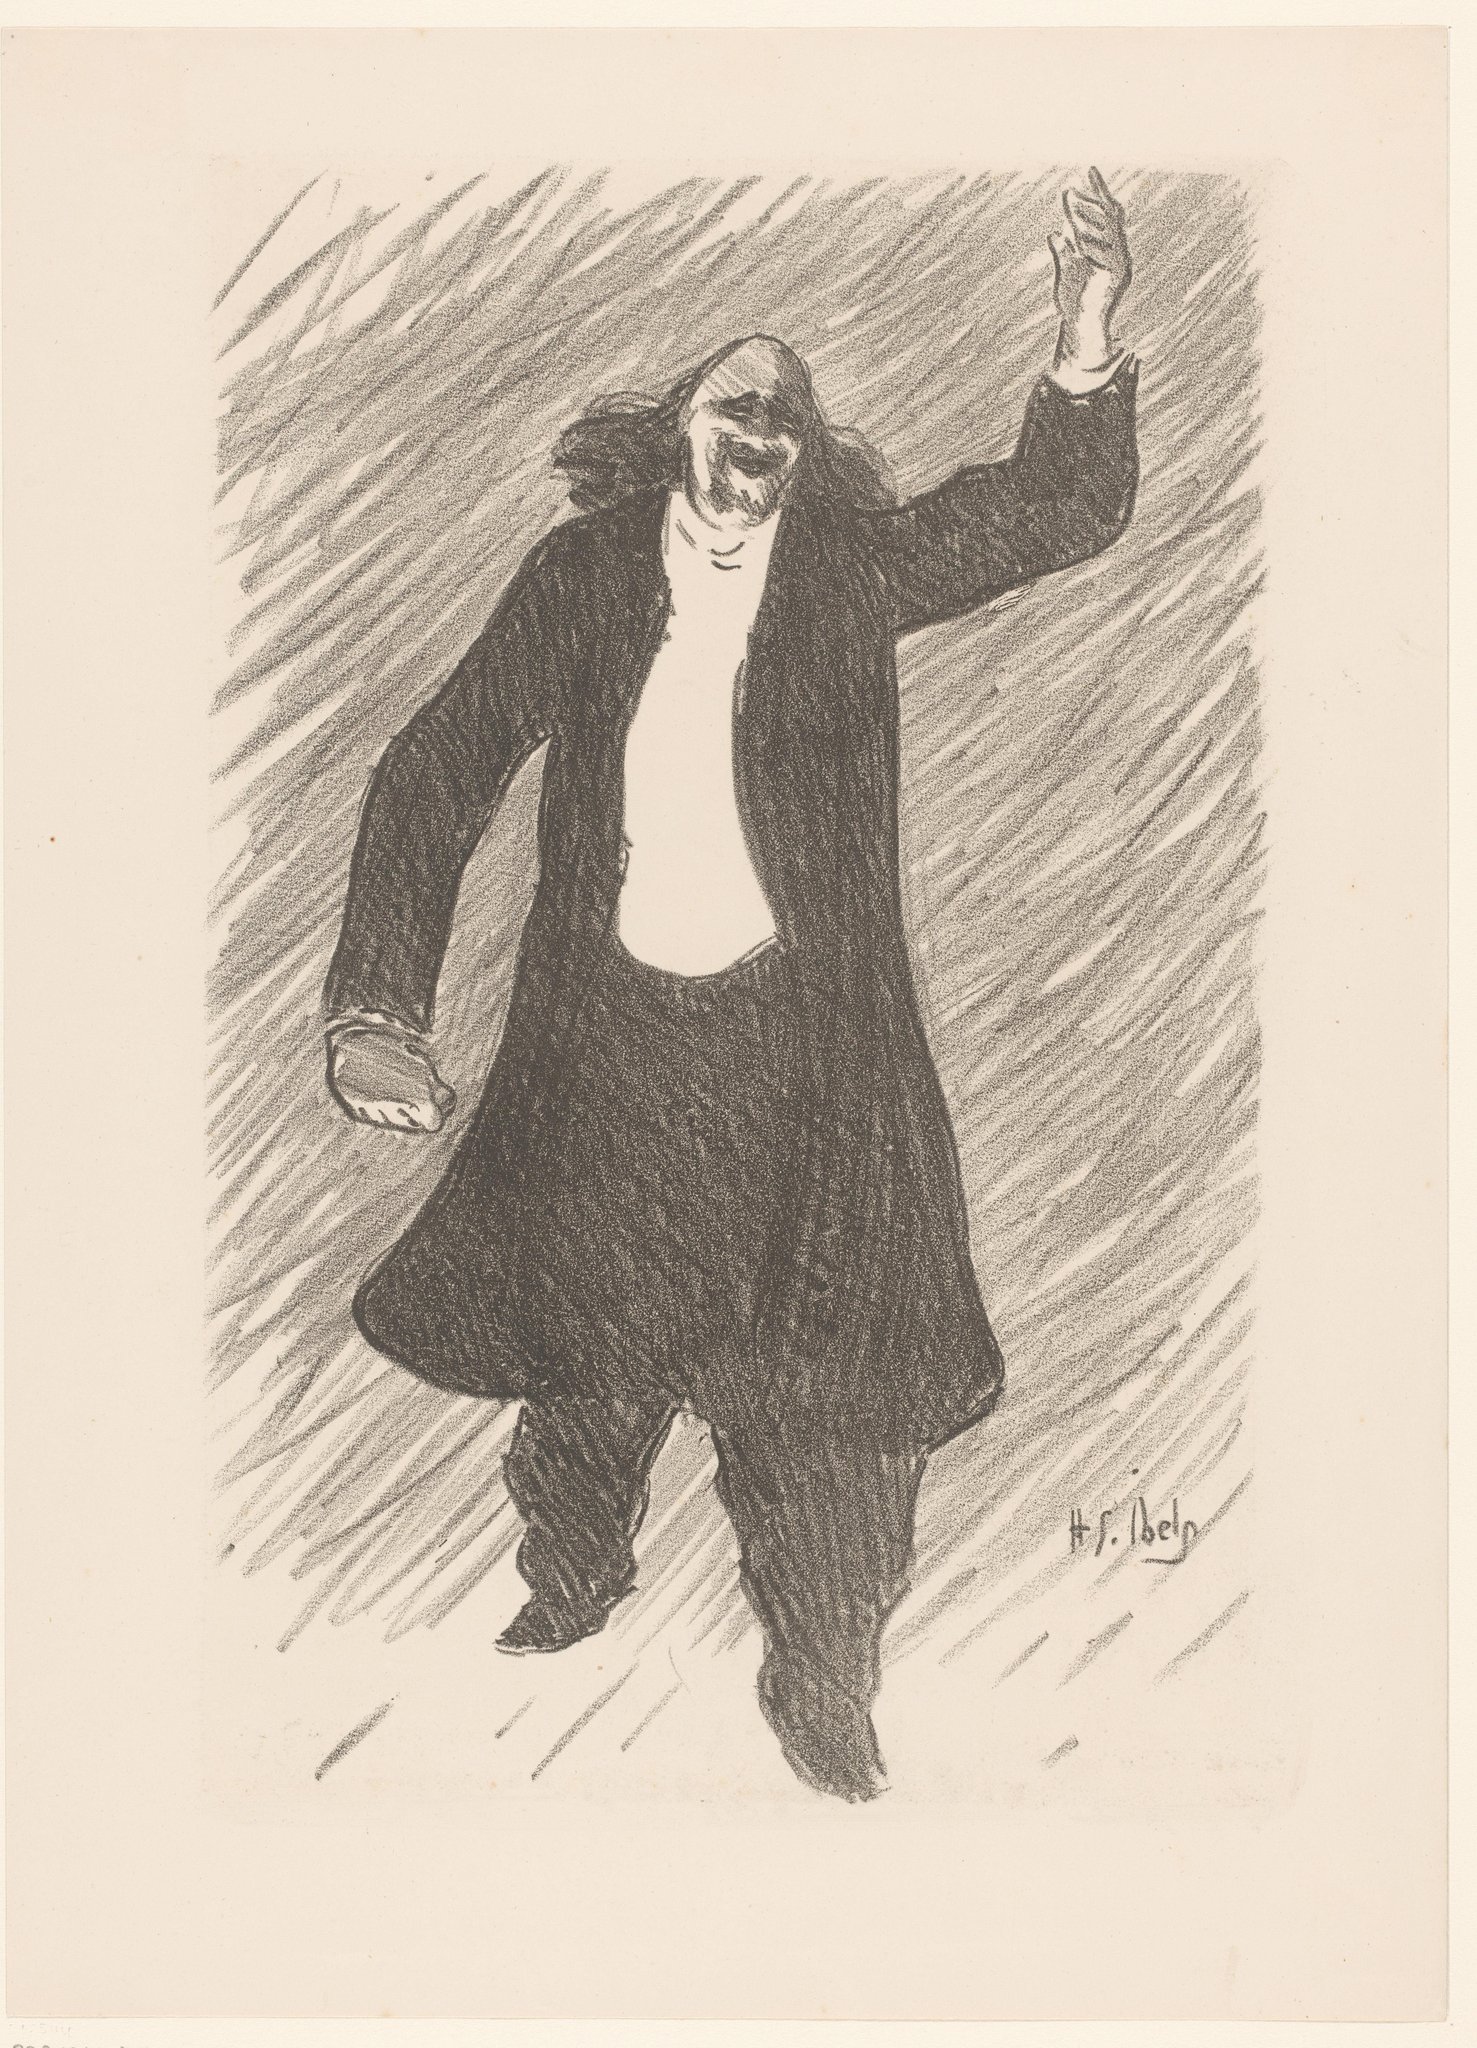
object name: print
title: Marcel Legay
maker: henri gabriel ibels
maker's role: print maker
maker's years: 1867-1936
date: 1893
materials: paper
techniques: lithography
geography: paris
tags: paris, historical persons, portrait of a musician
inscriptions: collector's mark: Lugt 2228a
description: Prent gebruikt voor: L'Estampe originale, 1893.